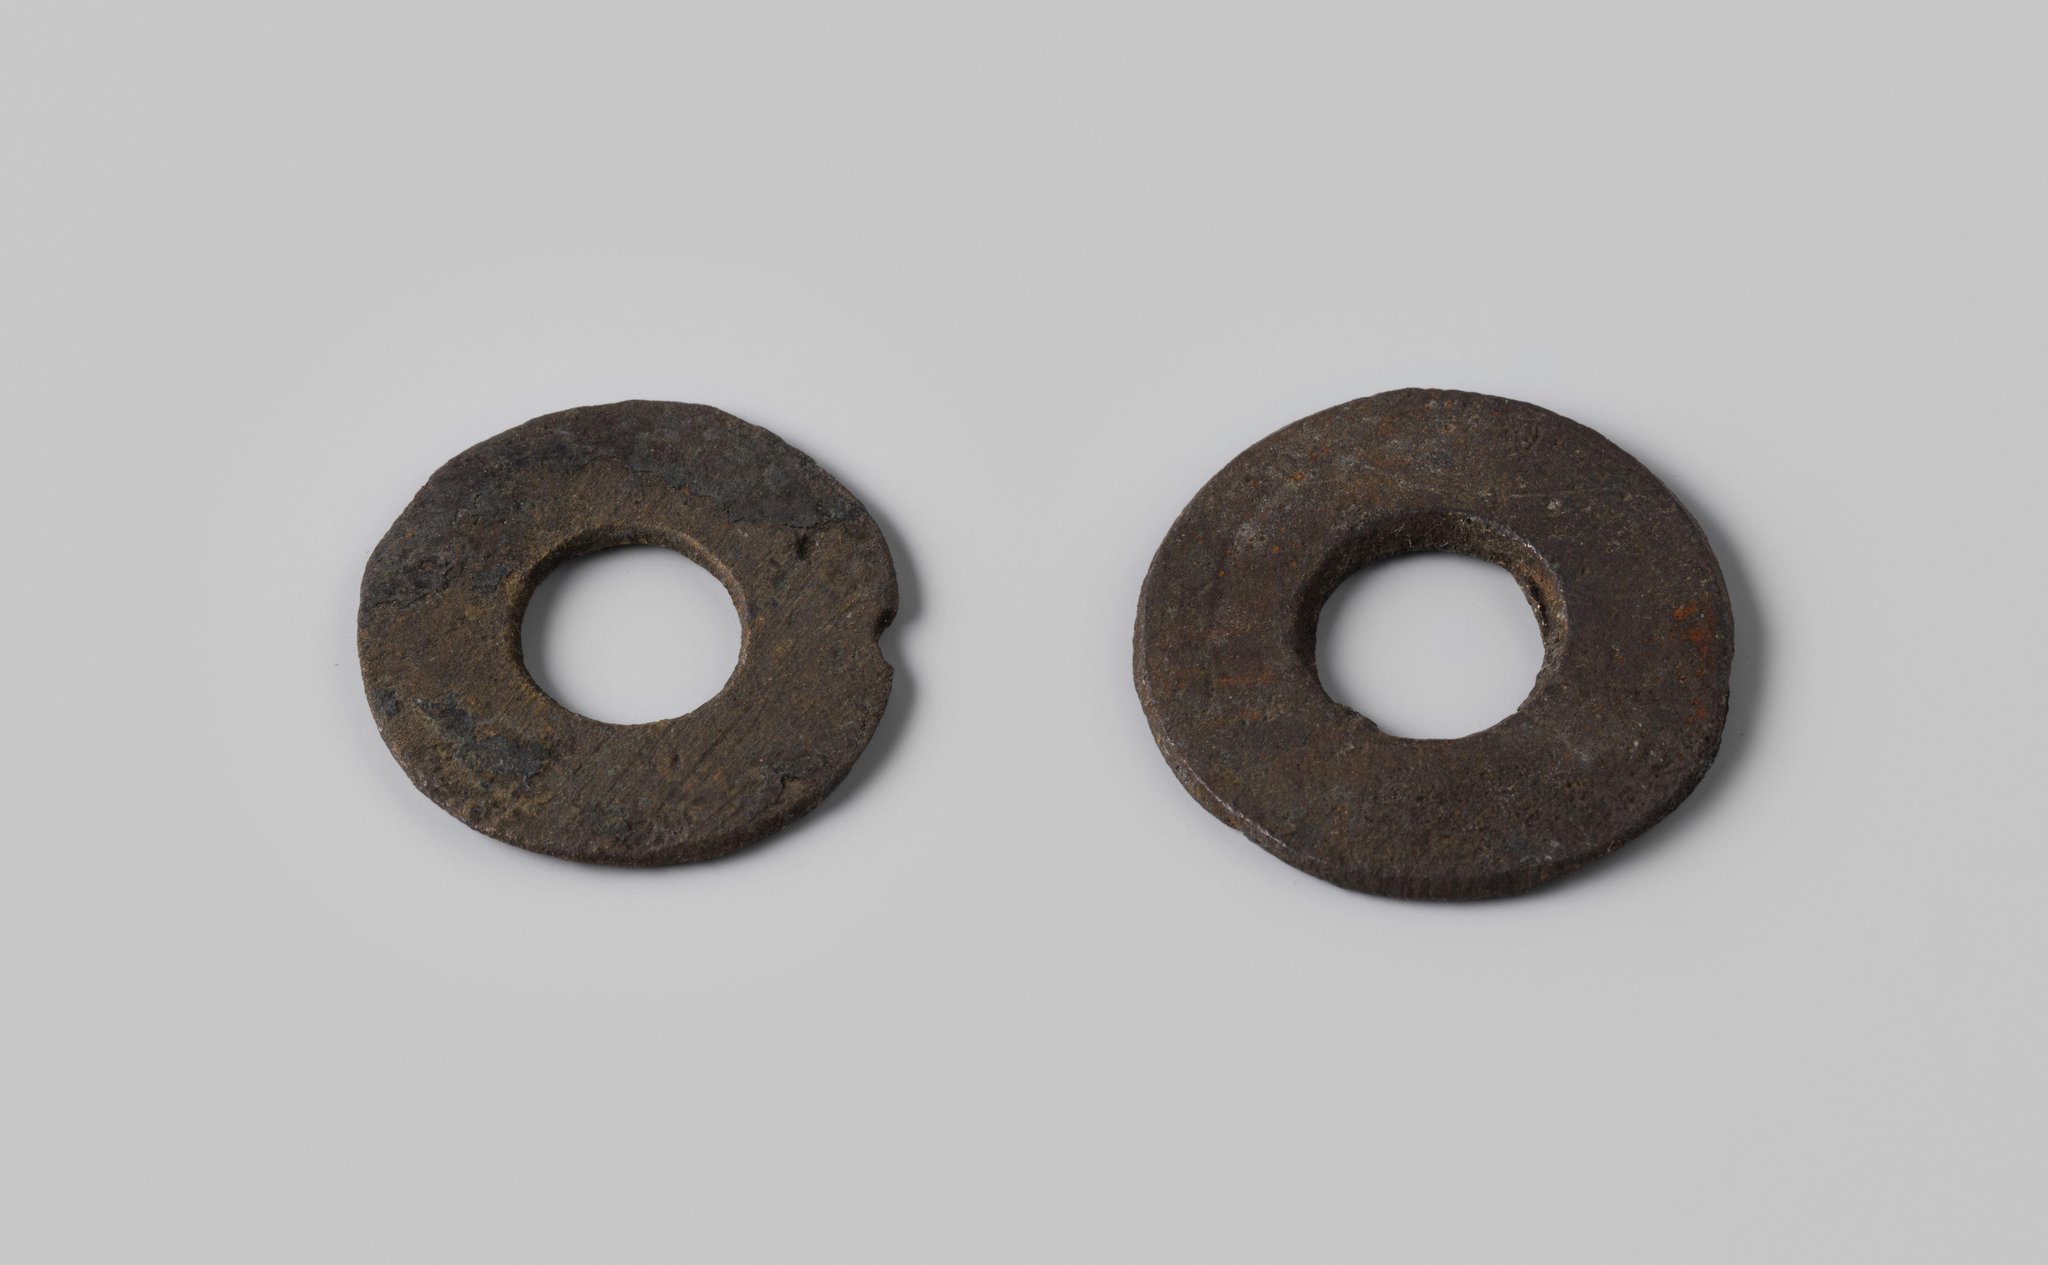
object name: sluitring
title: Sluitringen uit het wrak van de Oost-Indiëvaarder Hollandia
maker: Anonymous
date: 1700-1743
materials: copper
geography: netherlands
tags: verenigde oostindische compagnie, hollandia (schip), annet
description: Varied parts or fragments, washers; sim. 80H163.